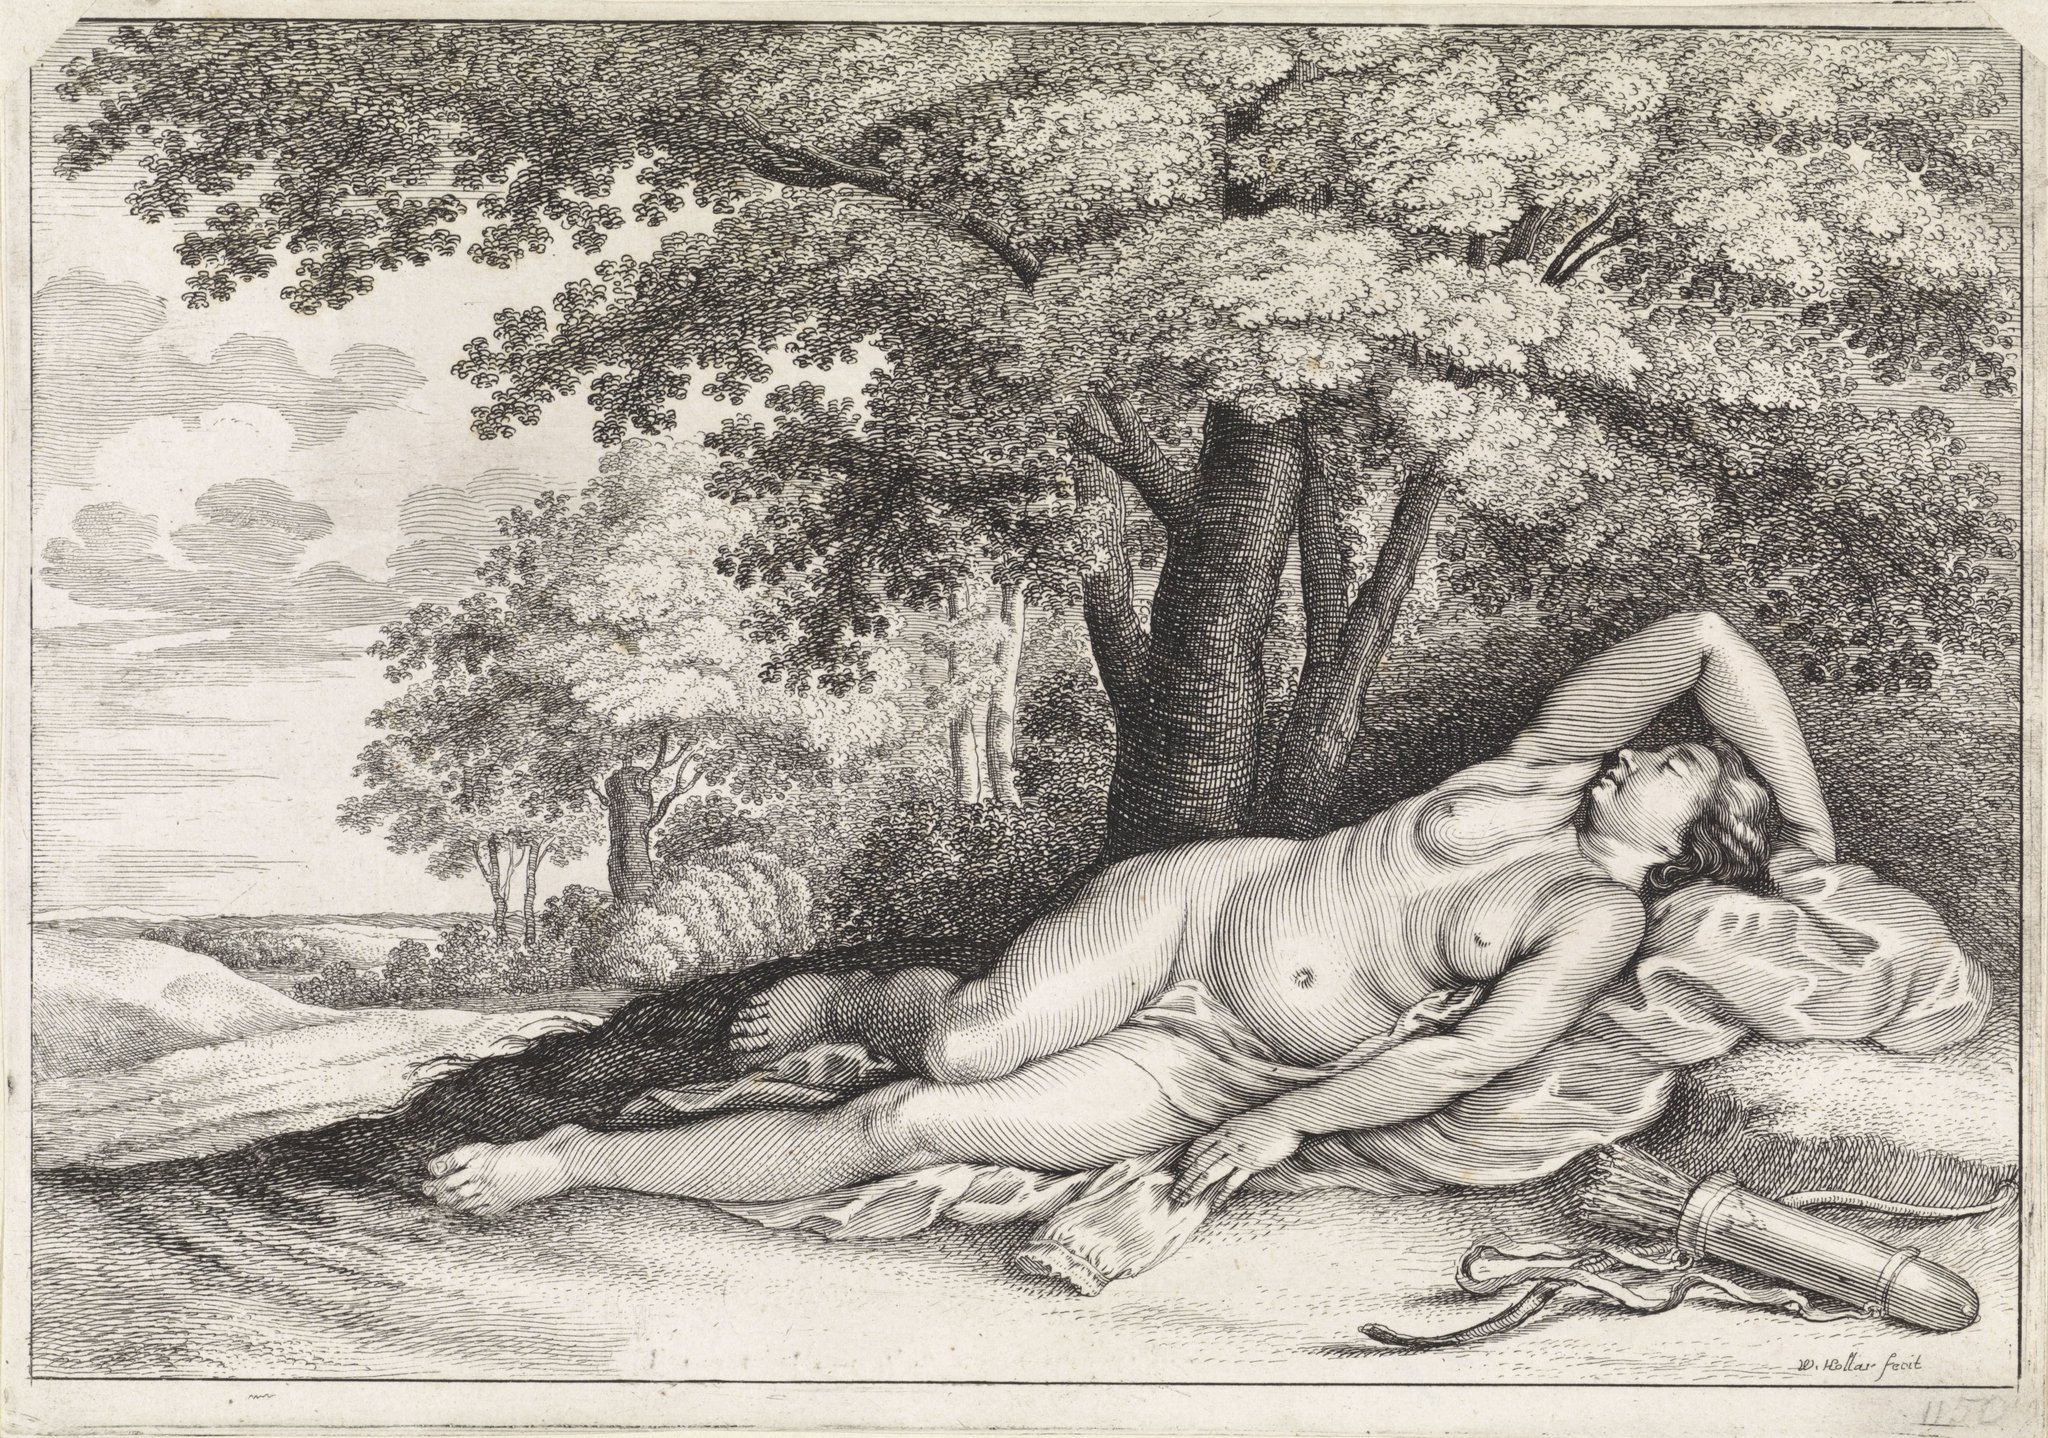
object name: print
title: Diana als jageres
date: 1616-1657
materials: paper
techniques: engraving, etching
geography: antwerp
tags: (story of) diana (artemis), sleeping; unconsciousness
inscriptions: collector's mark: Lugt 240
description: De naakte godin Diana slaapt onder een boom. Haar pijlenkoker ligt naast haar.